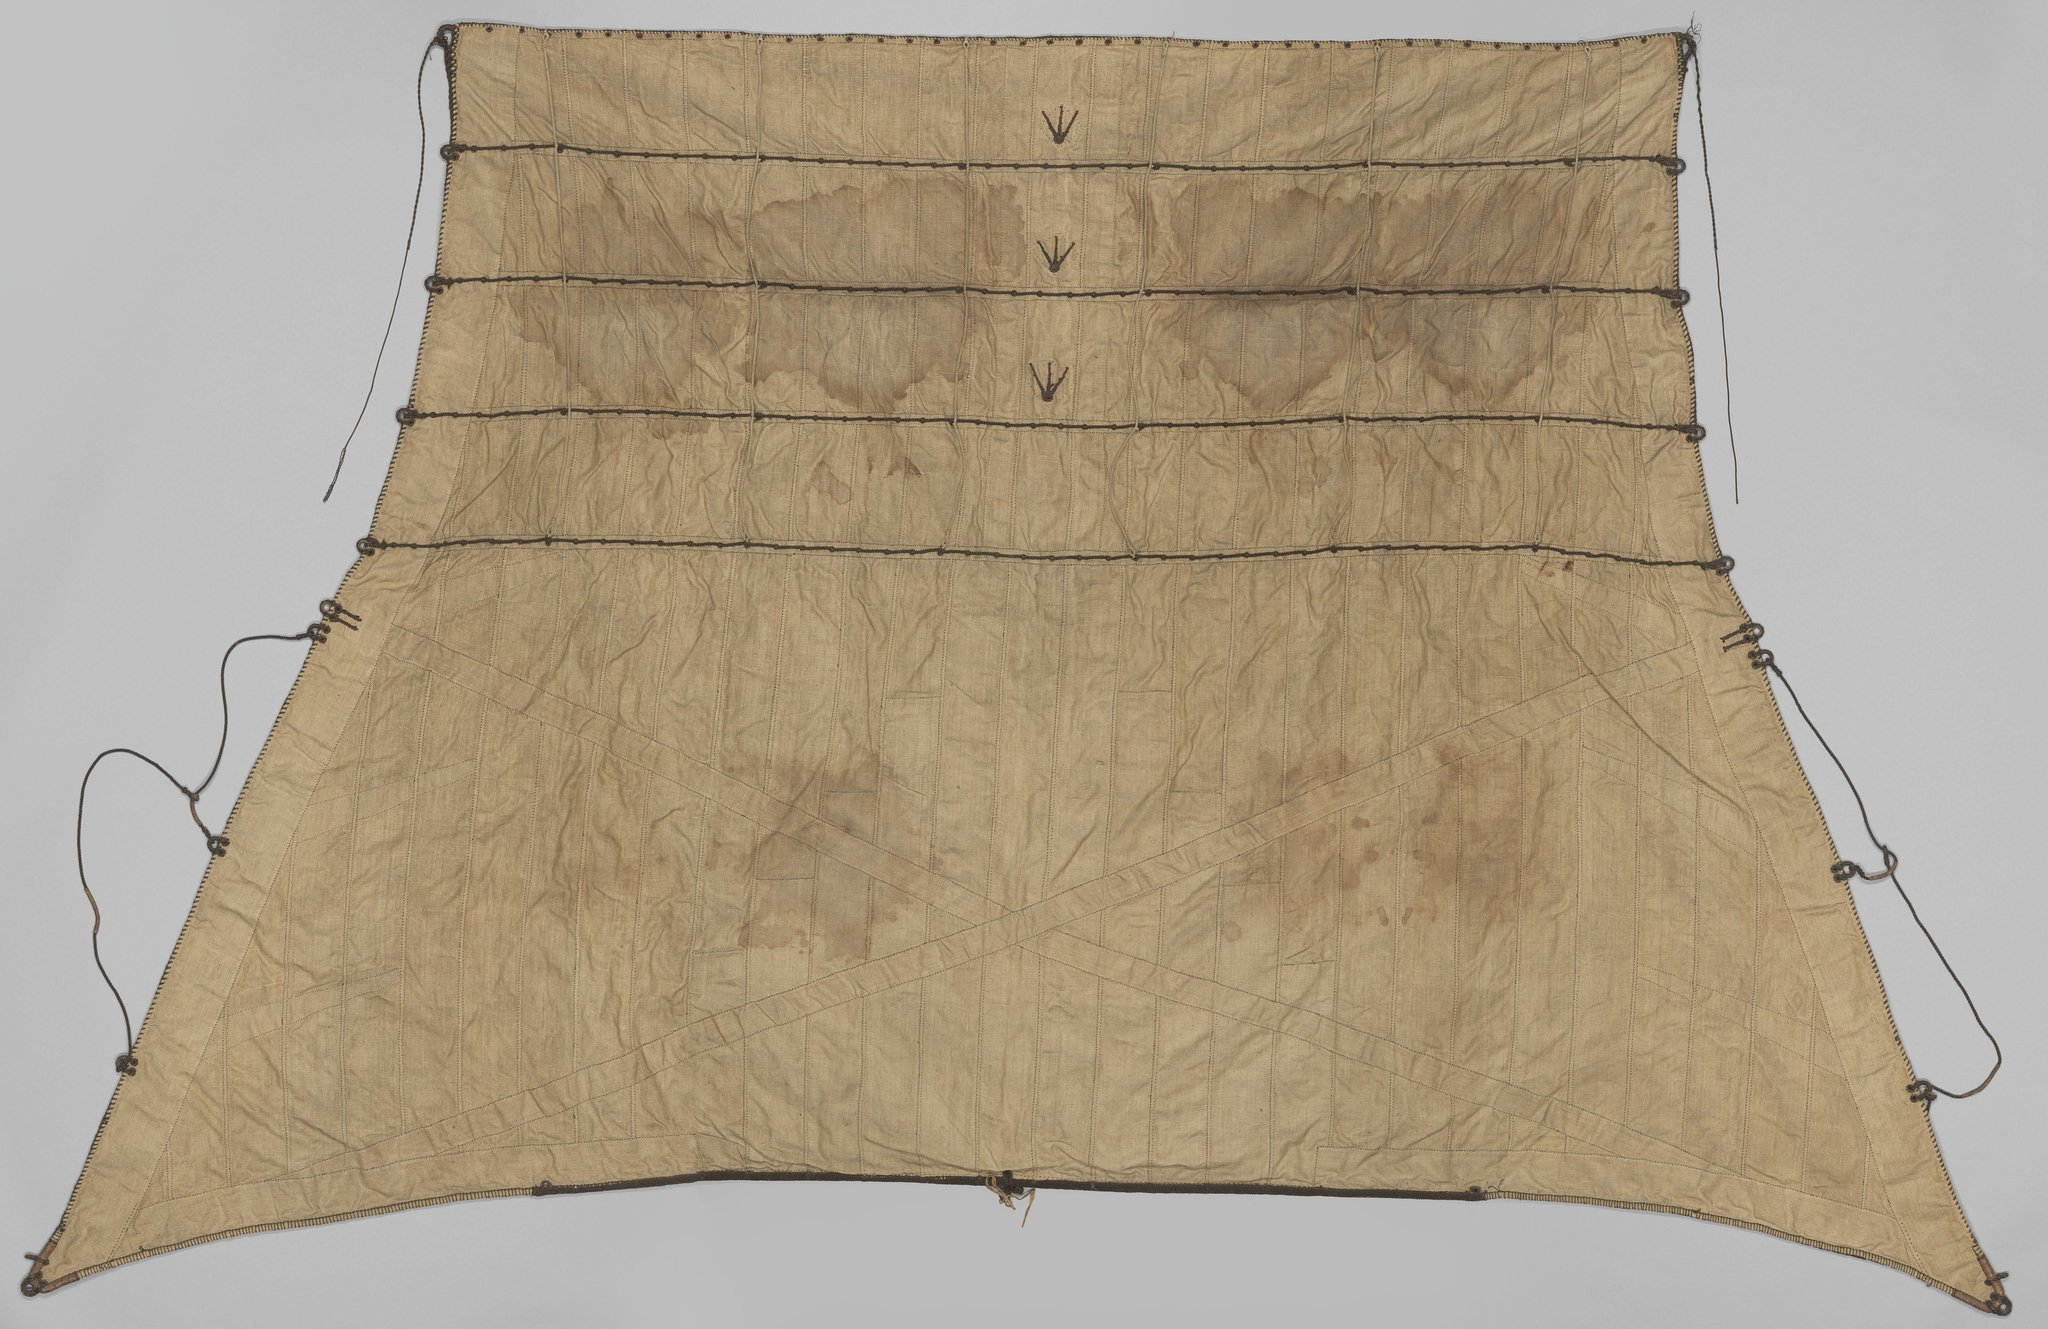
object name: demonstration model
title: Model of a Topsail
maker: Anonymous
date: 1861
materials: brass, leather, fiber, textile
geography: netherlands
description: Model van een marszeil van een en twintig zeilkleden boven en een en dertig beneden, met kruisbanden, vier reven, drie popstroppen, boelijnspruiten en schoothoorns, verstevigd met leer. De reven bestaan uit rifleiders in plaats van rifseizing: de rifleiders zijn over de rifbanden lopende touwen, die bij de rifgaten vastgestikt zijn; door dit touw worden bij het reven knevels gehaald, die op een touw of ijzeren stang aan de ra bevestigd zijn. Zes verticale touwen, die, waar zij de rifbanden kruisen, zijn vastgestikt, dienen om het zeil op te halen bij het reven. Schaal 1:10 (afgeleid).